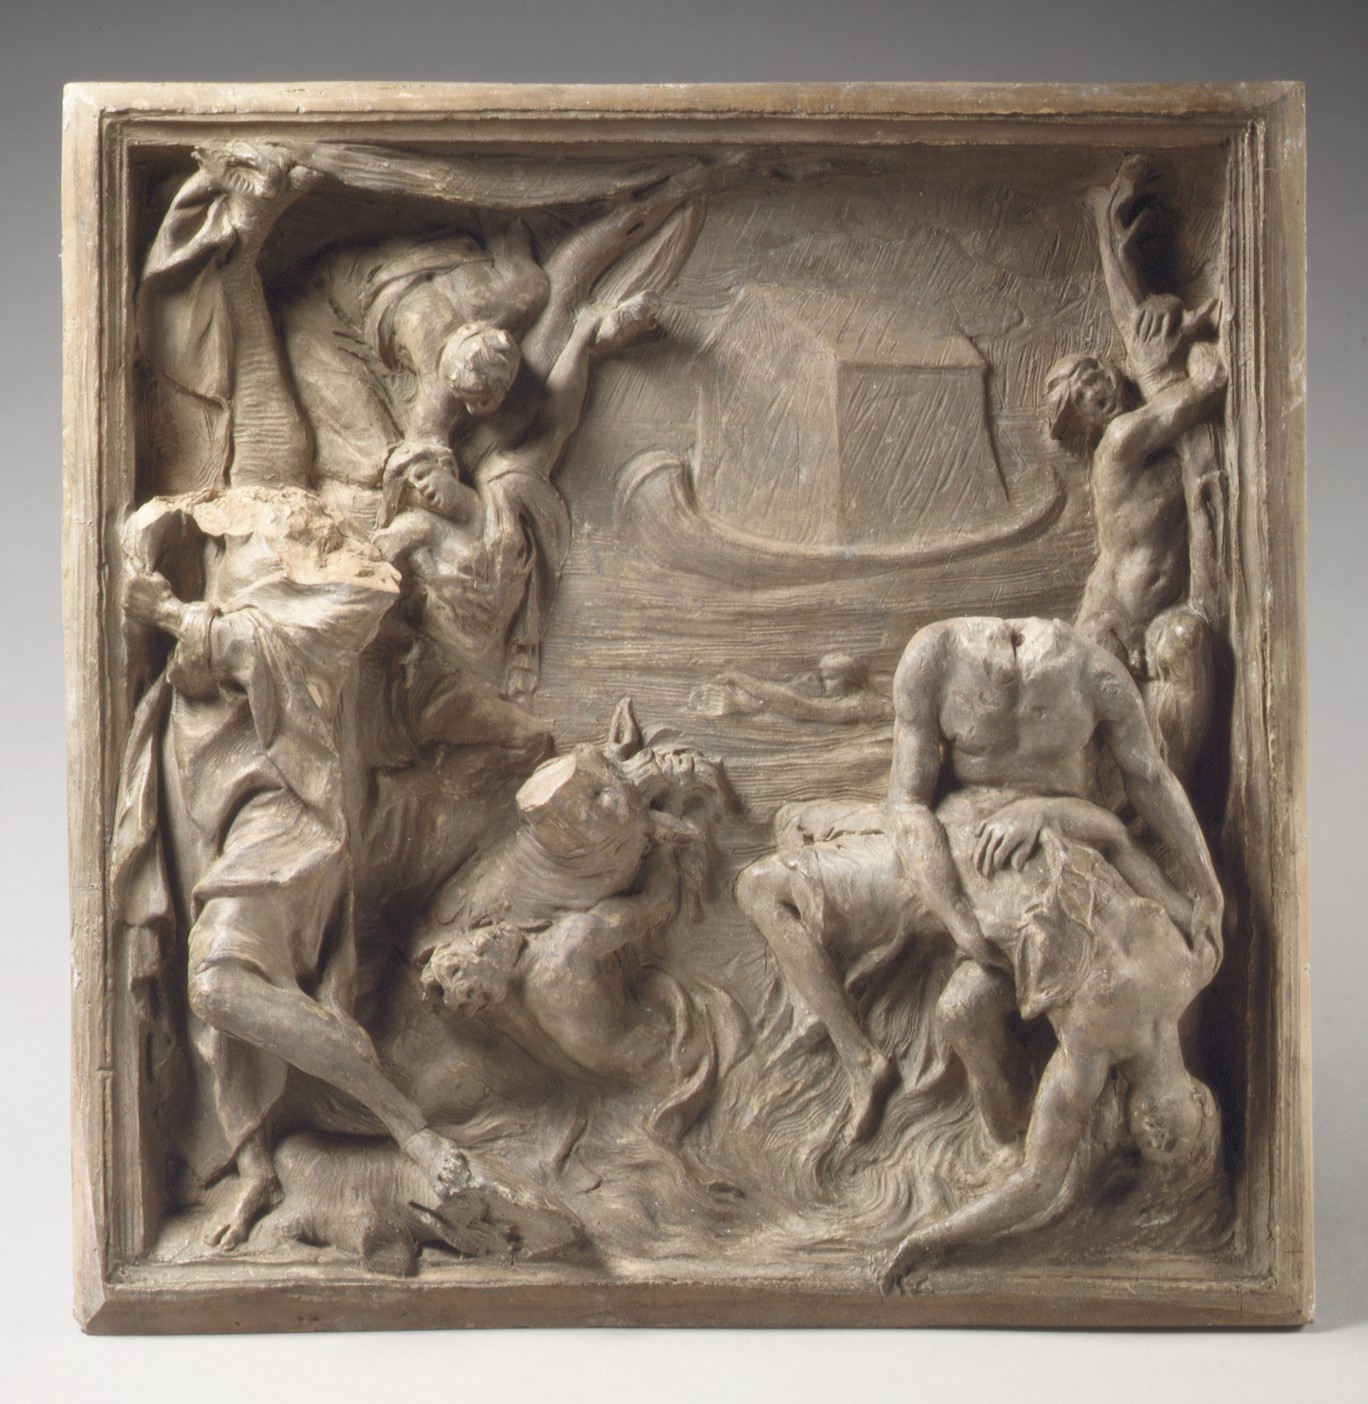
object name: relief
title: The Flood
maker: michel anguier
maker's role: artist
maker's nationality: french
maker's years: 1612-1686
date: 1648-1649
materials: terracotta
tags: human figures,floods